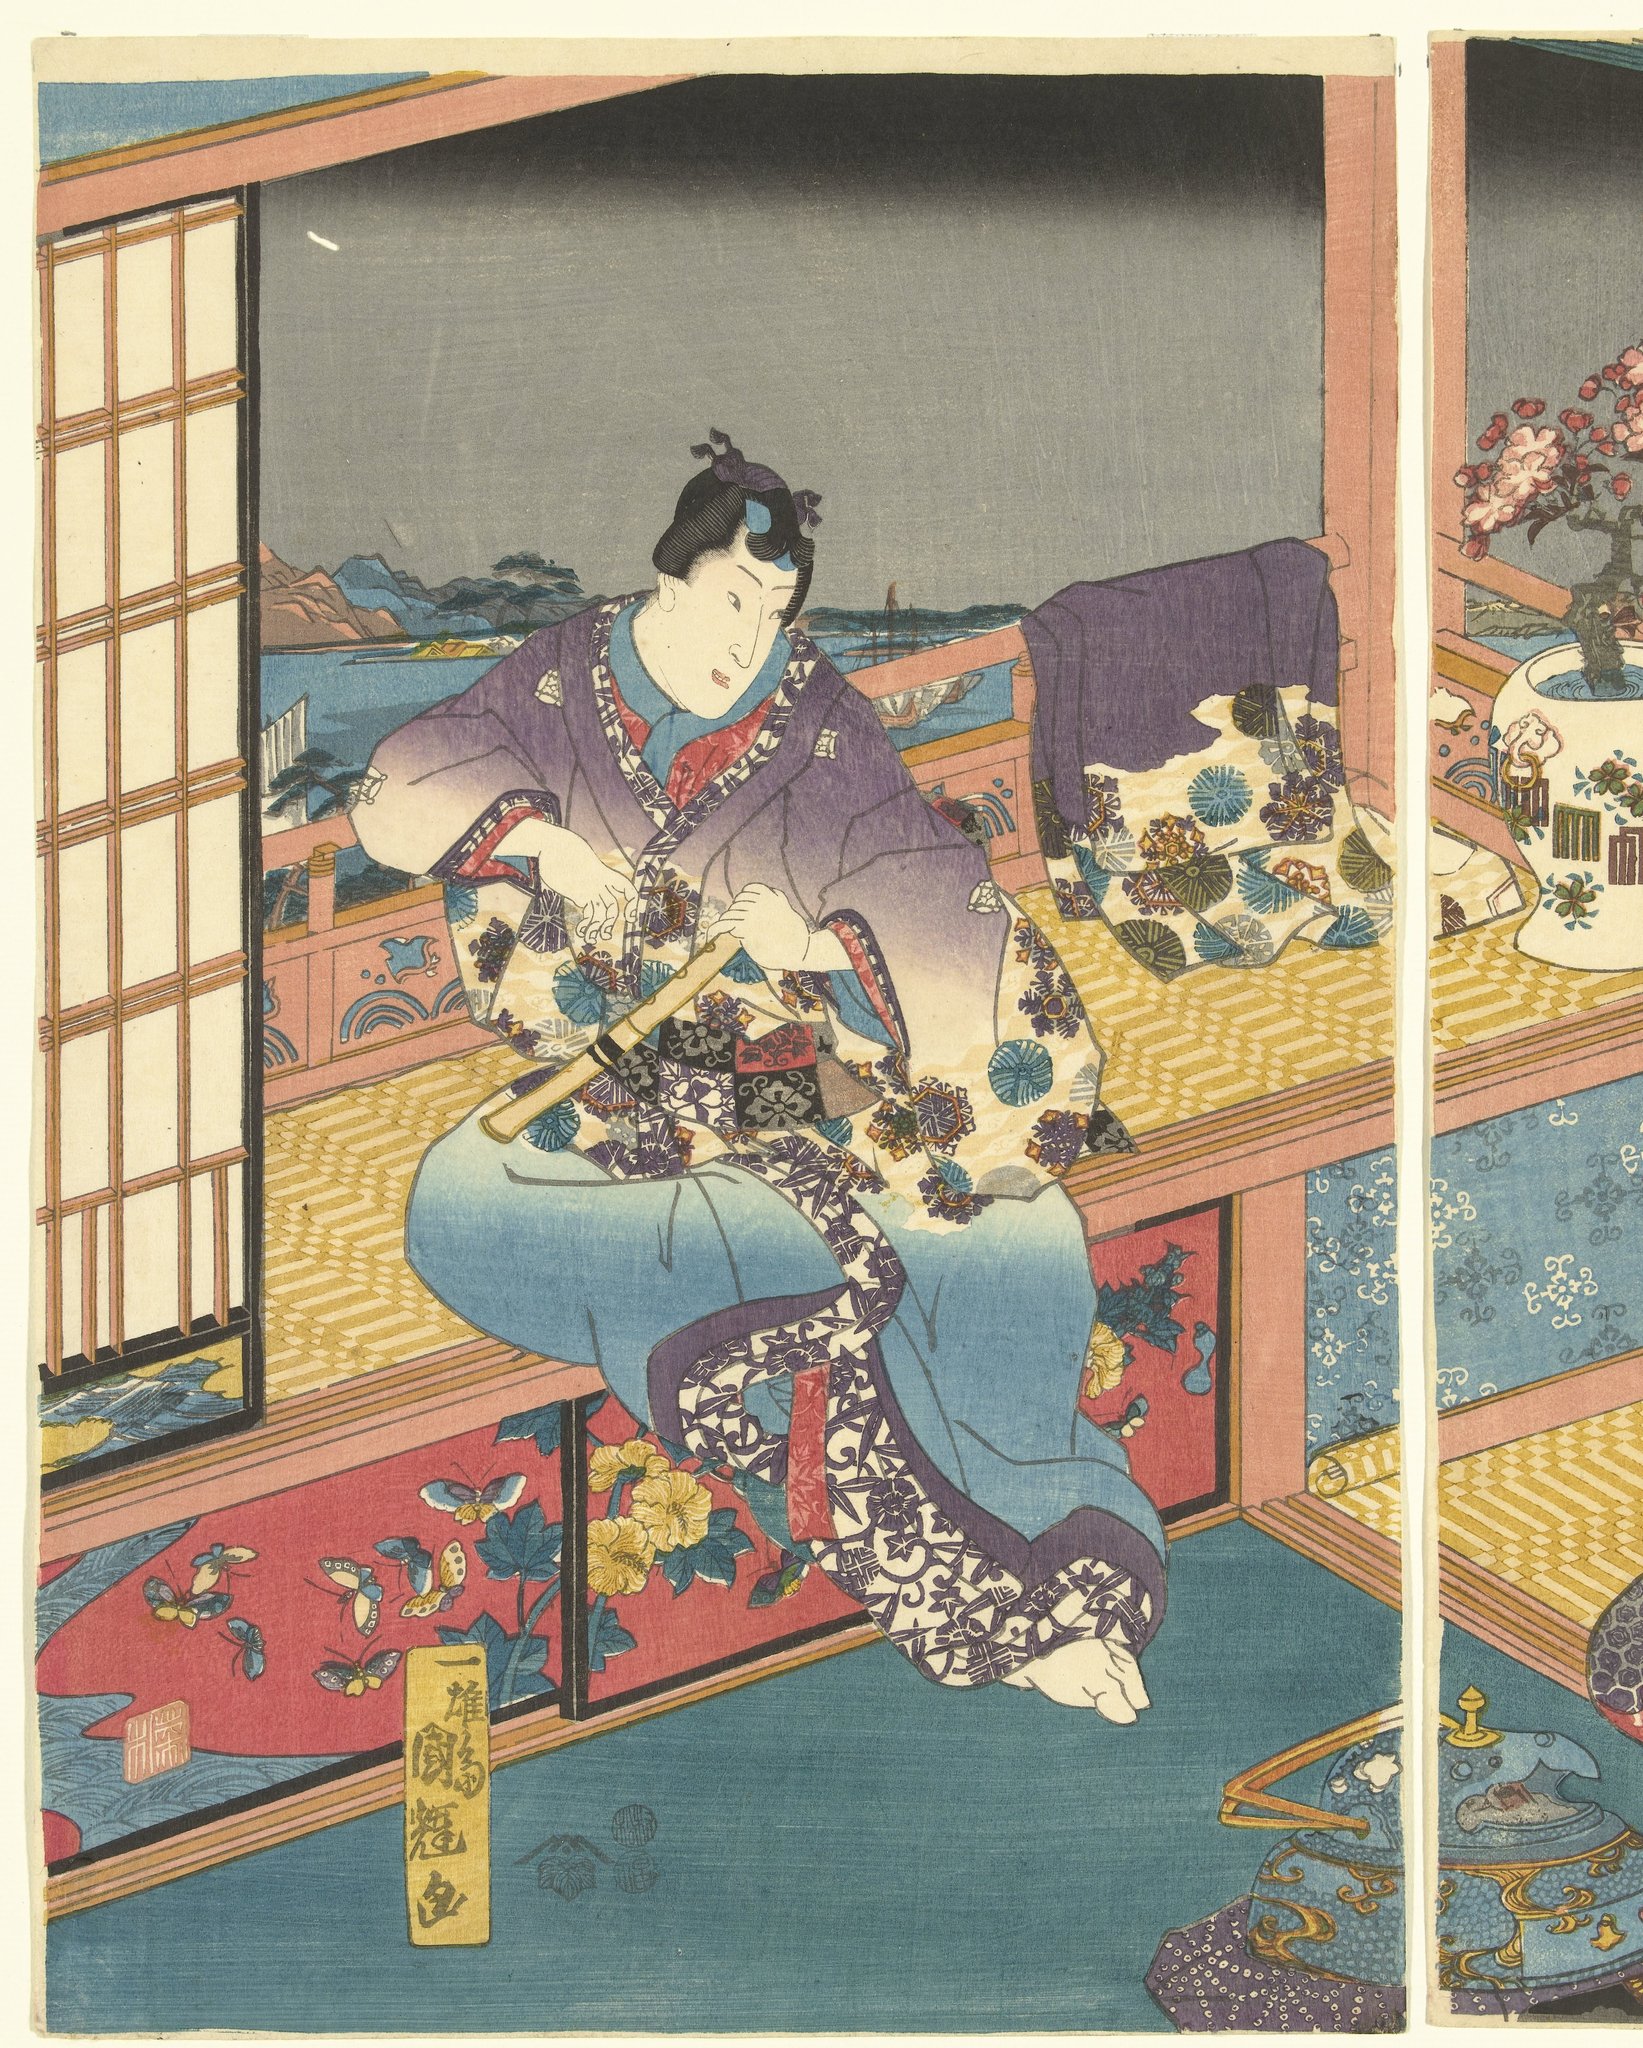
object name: print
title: Sneeuw, maan en bloemen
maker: utagawa kuniteru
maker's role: print maker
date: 1850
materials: paper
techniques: woodcut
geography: japan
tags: one person playing an instrument